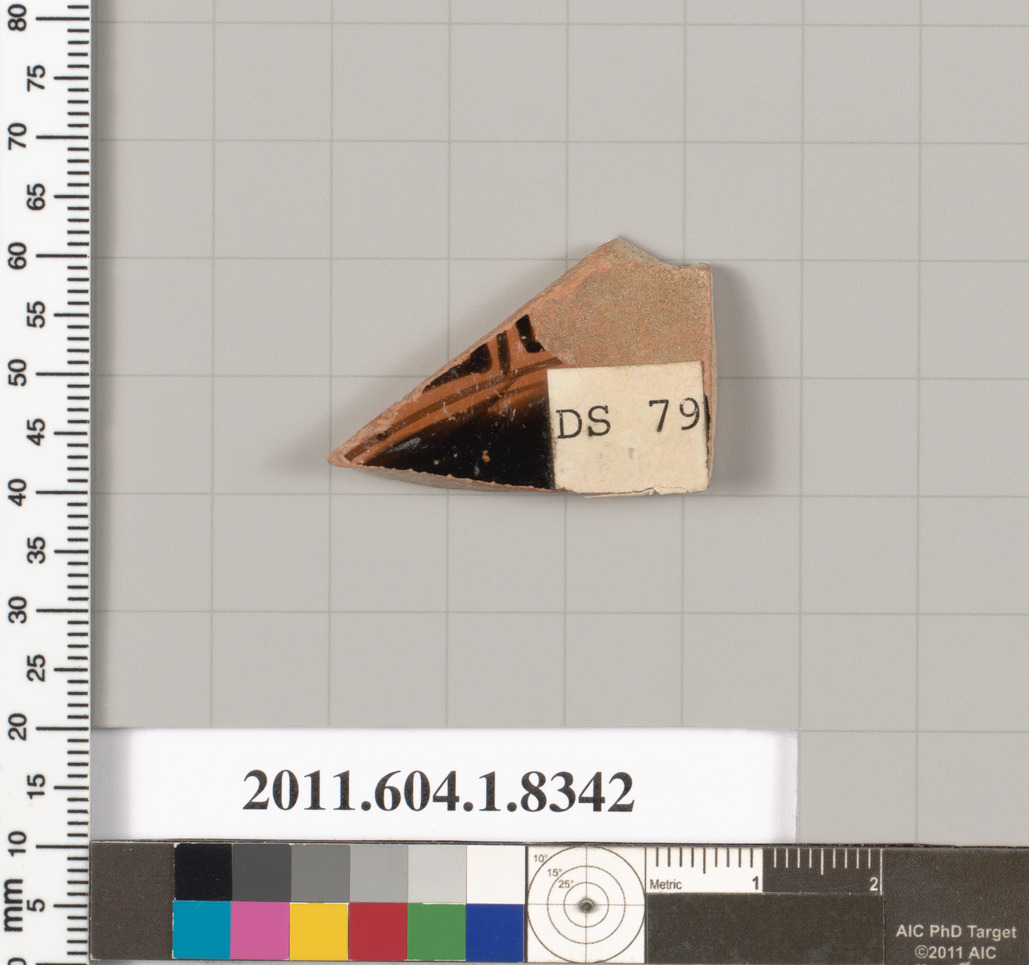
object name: kylix fragment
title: Terracotta fragment of a kylix (drinking cup)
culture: greek, attic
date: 425-401 BCE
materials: terracotta